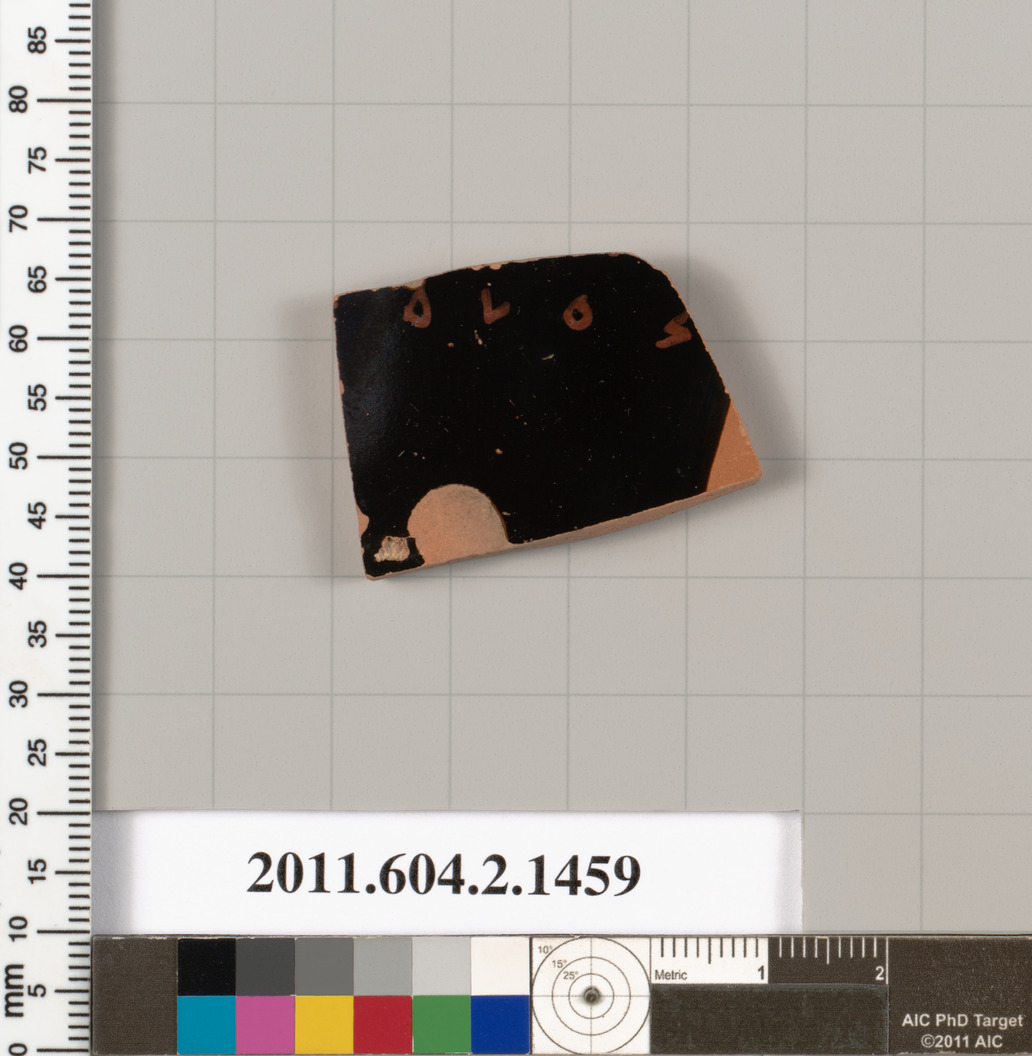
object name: skyphos fragment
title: Terracotta fragment of a skyphos (deep drinking cup)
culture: greek, attic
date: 475-451 BCE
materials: terracotta